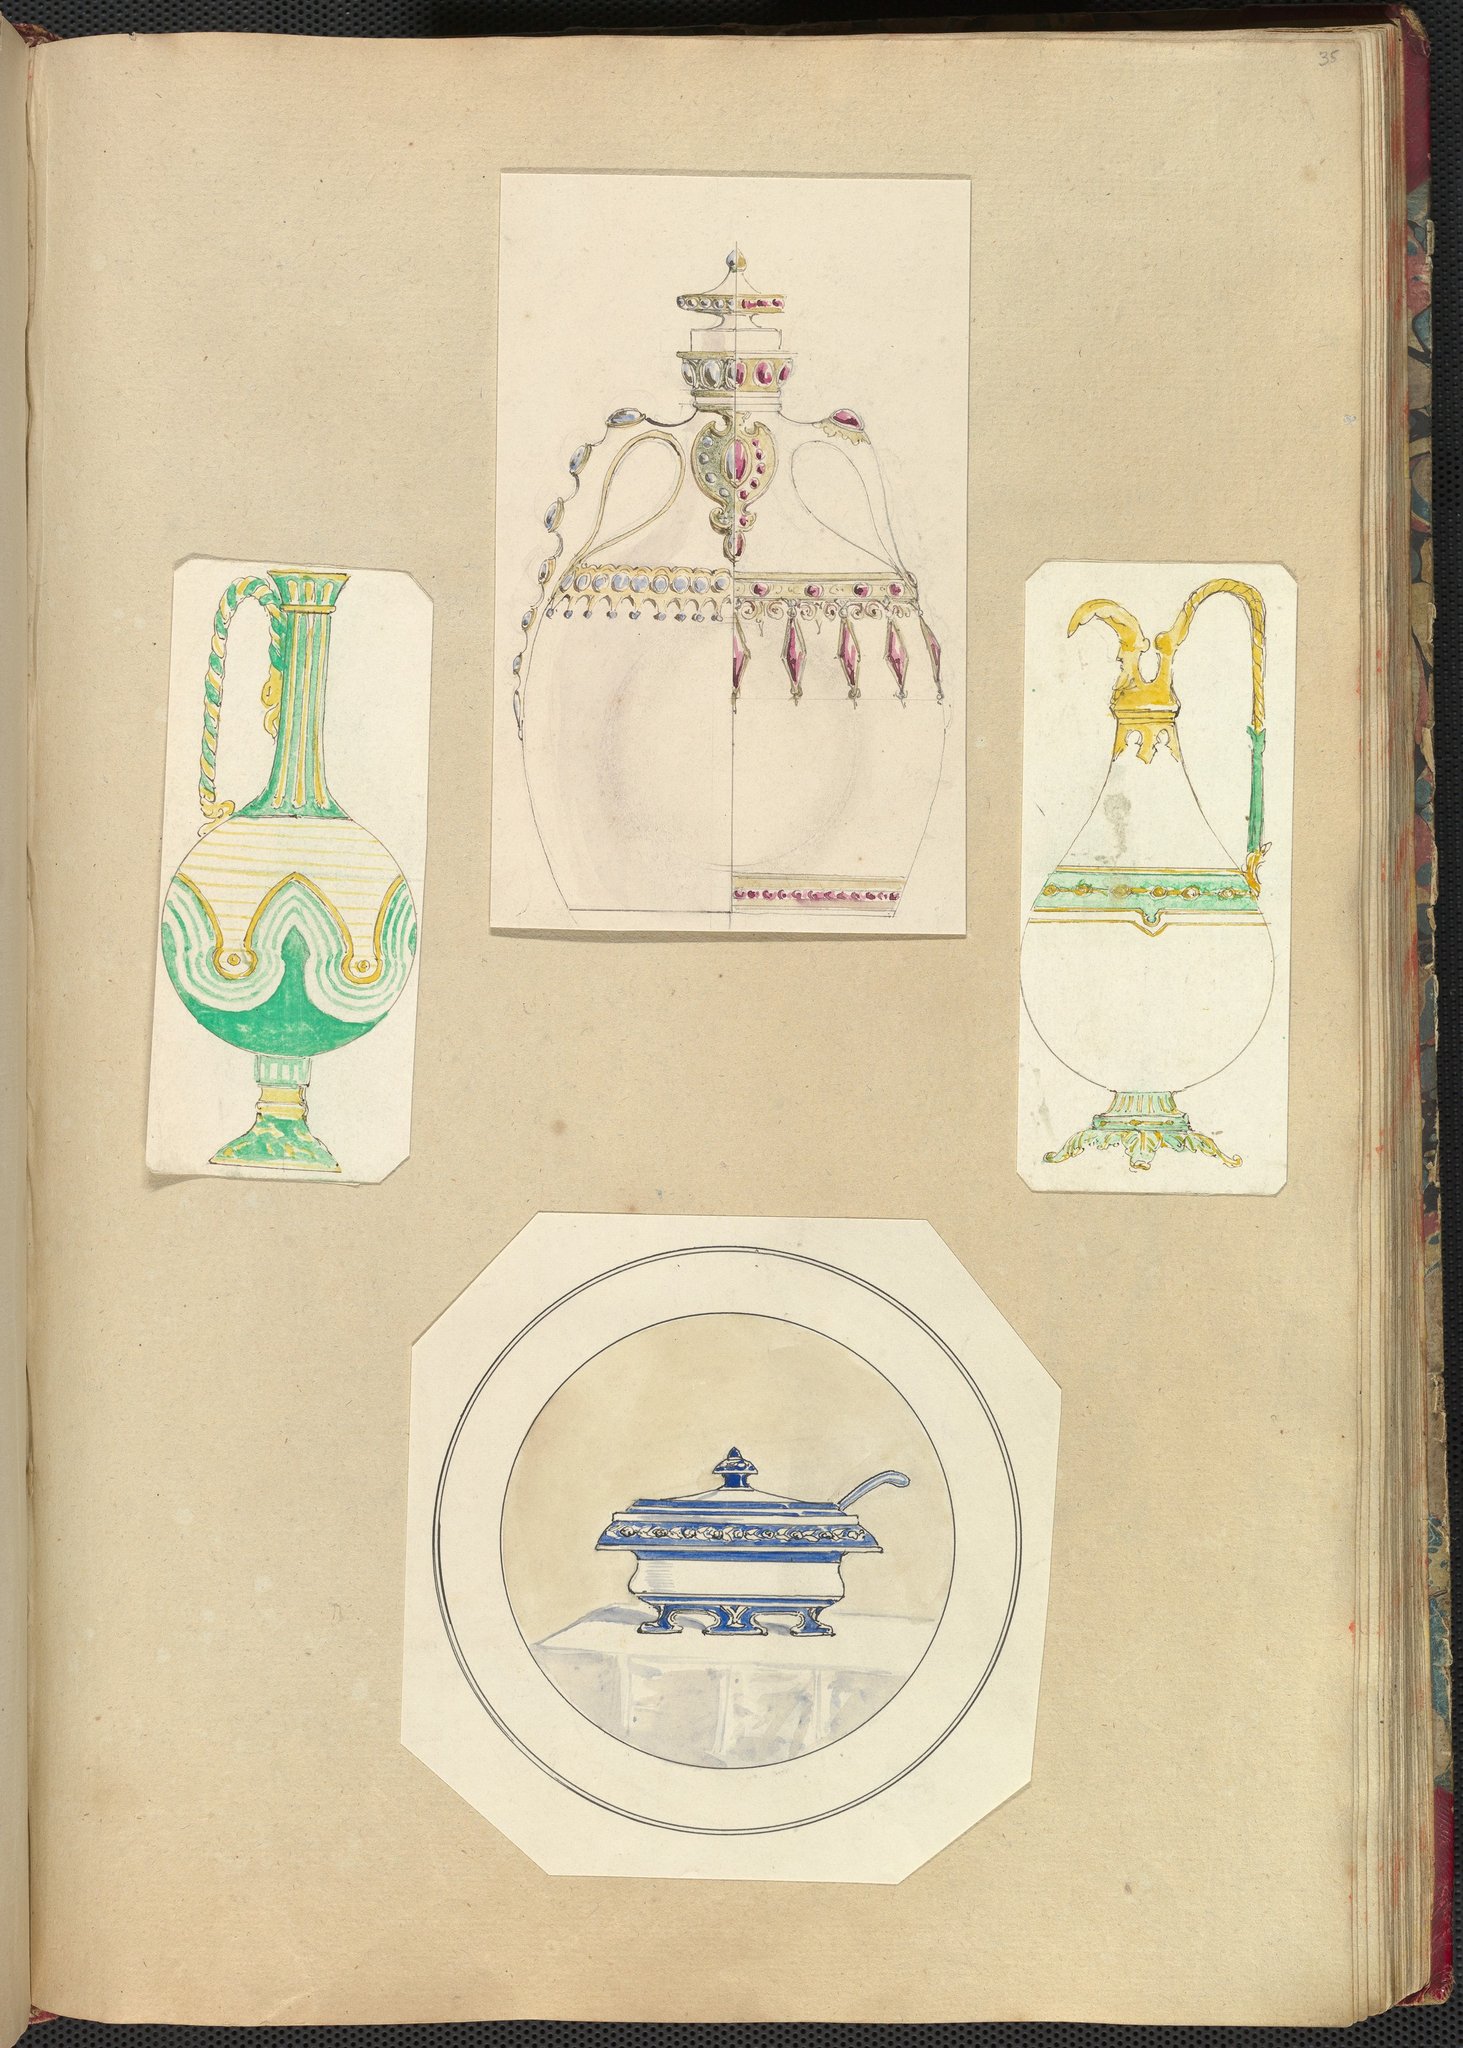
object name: drawing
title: Designs for Two Ewers, a Carafe (two alternate designs), and a Covered Tureen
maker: alfred henry forrester [alfred crowquill]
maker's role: artist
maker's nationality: british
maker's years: 1804-1872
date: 1845-1855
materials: ink, watercolor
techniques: pen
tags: ewers